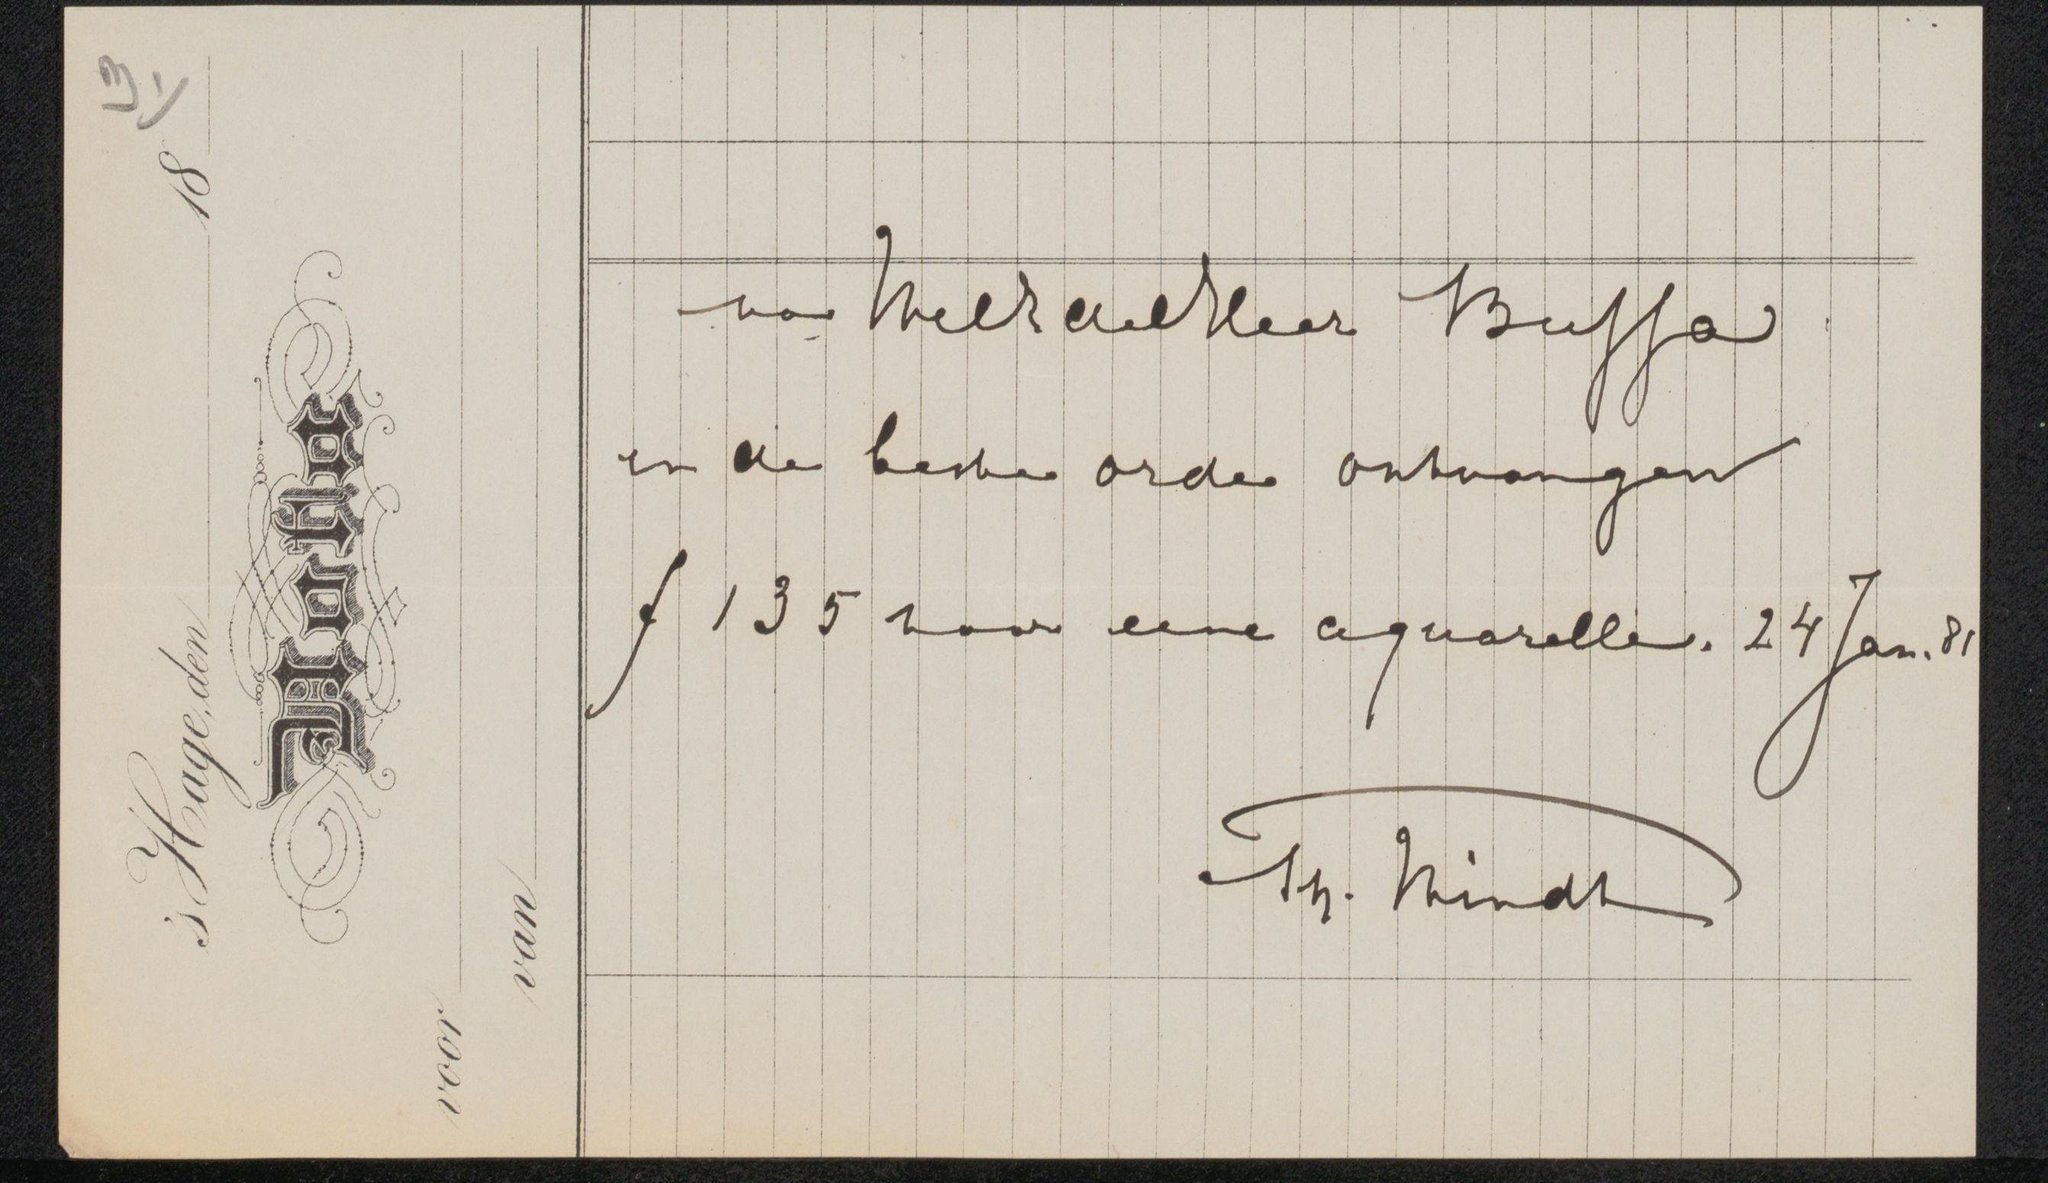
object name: ontvangstbewijs, kwitantie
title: Kwitantie voor Philip Windt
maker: philip windt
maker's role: draughtsman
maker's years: 1847-1921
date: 1881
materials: ink, paper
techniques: pen, printing, writing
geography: the hague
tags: publisher, drawing, money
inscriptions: collector's mark: Lugt 2233